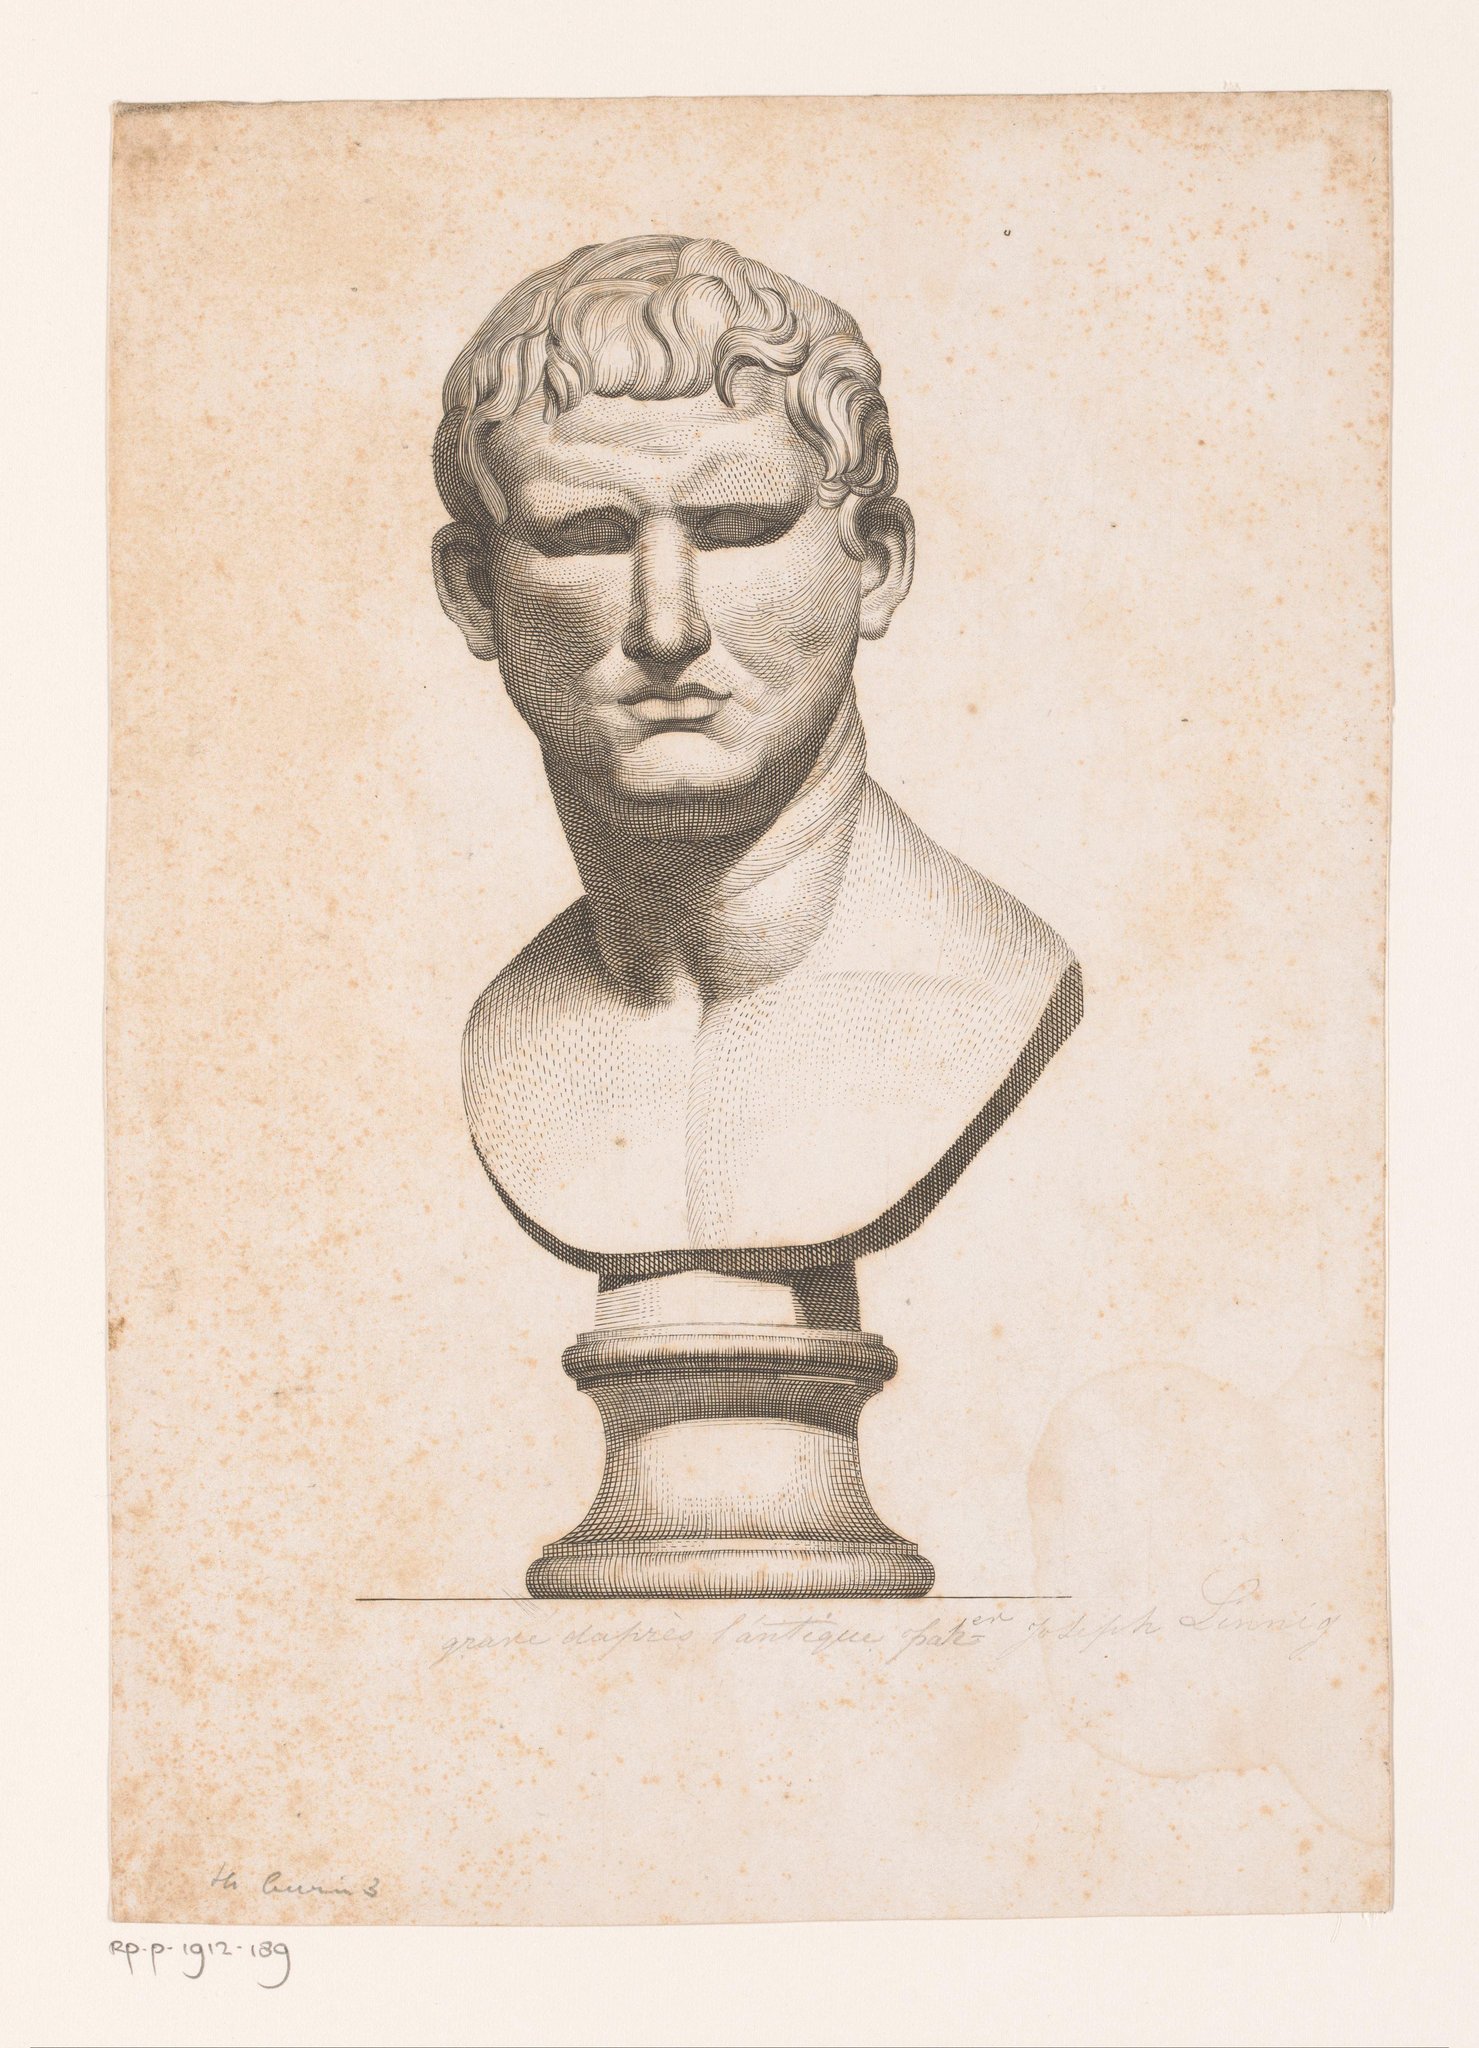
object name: print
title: Antieke buste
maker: jean théodore joseph linnig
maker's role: draughtsman, print maker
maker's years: 1815-1891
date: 1825-1891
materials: paper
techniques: engraving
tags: chest, bust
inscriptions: annotation: ‘gravé d'après l'antique par Joseph Linnig’, collector's mark: Lugt 1485, collector's mark: Lugt 2228